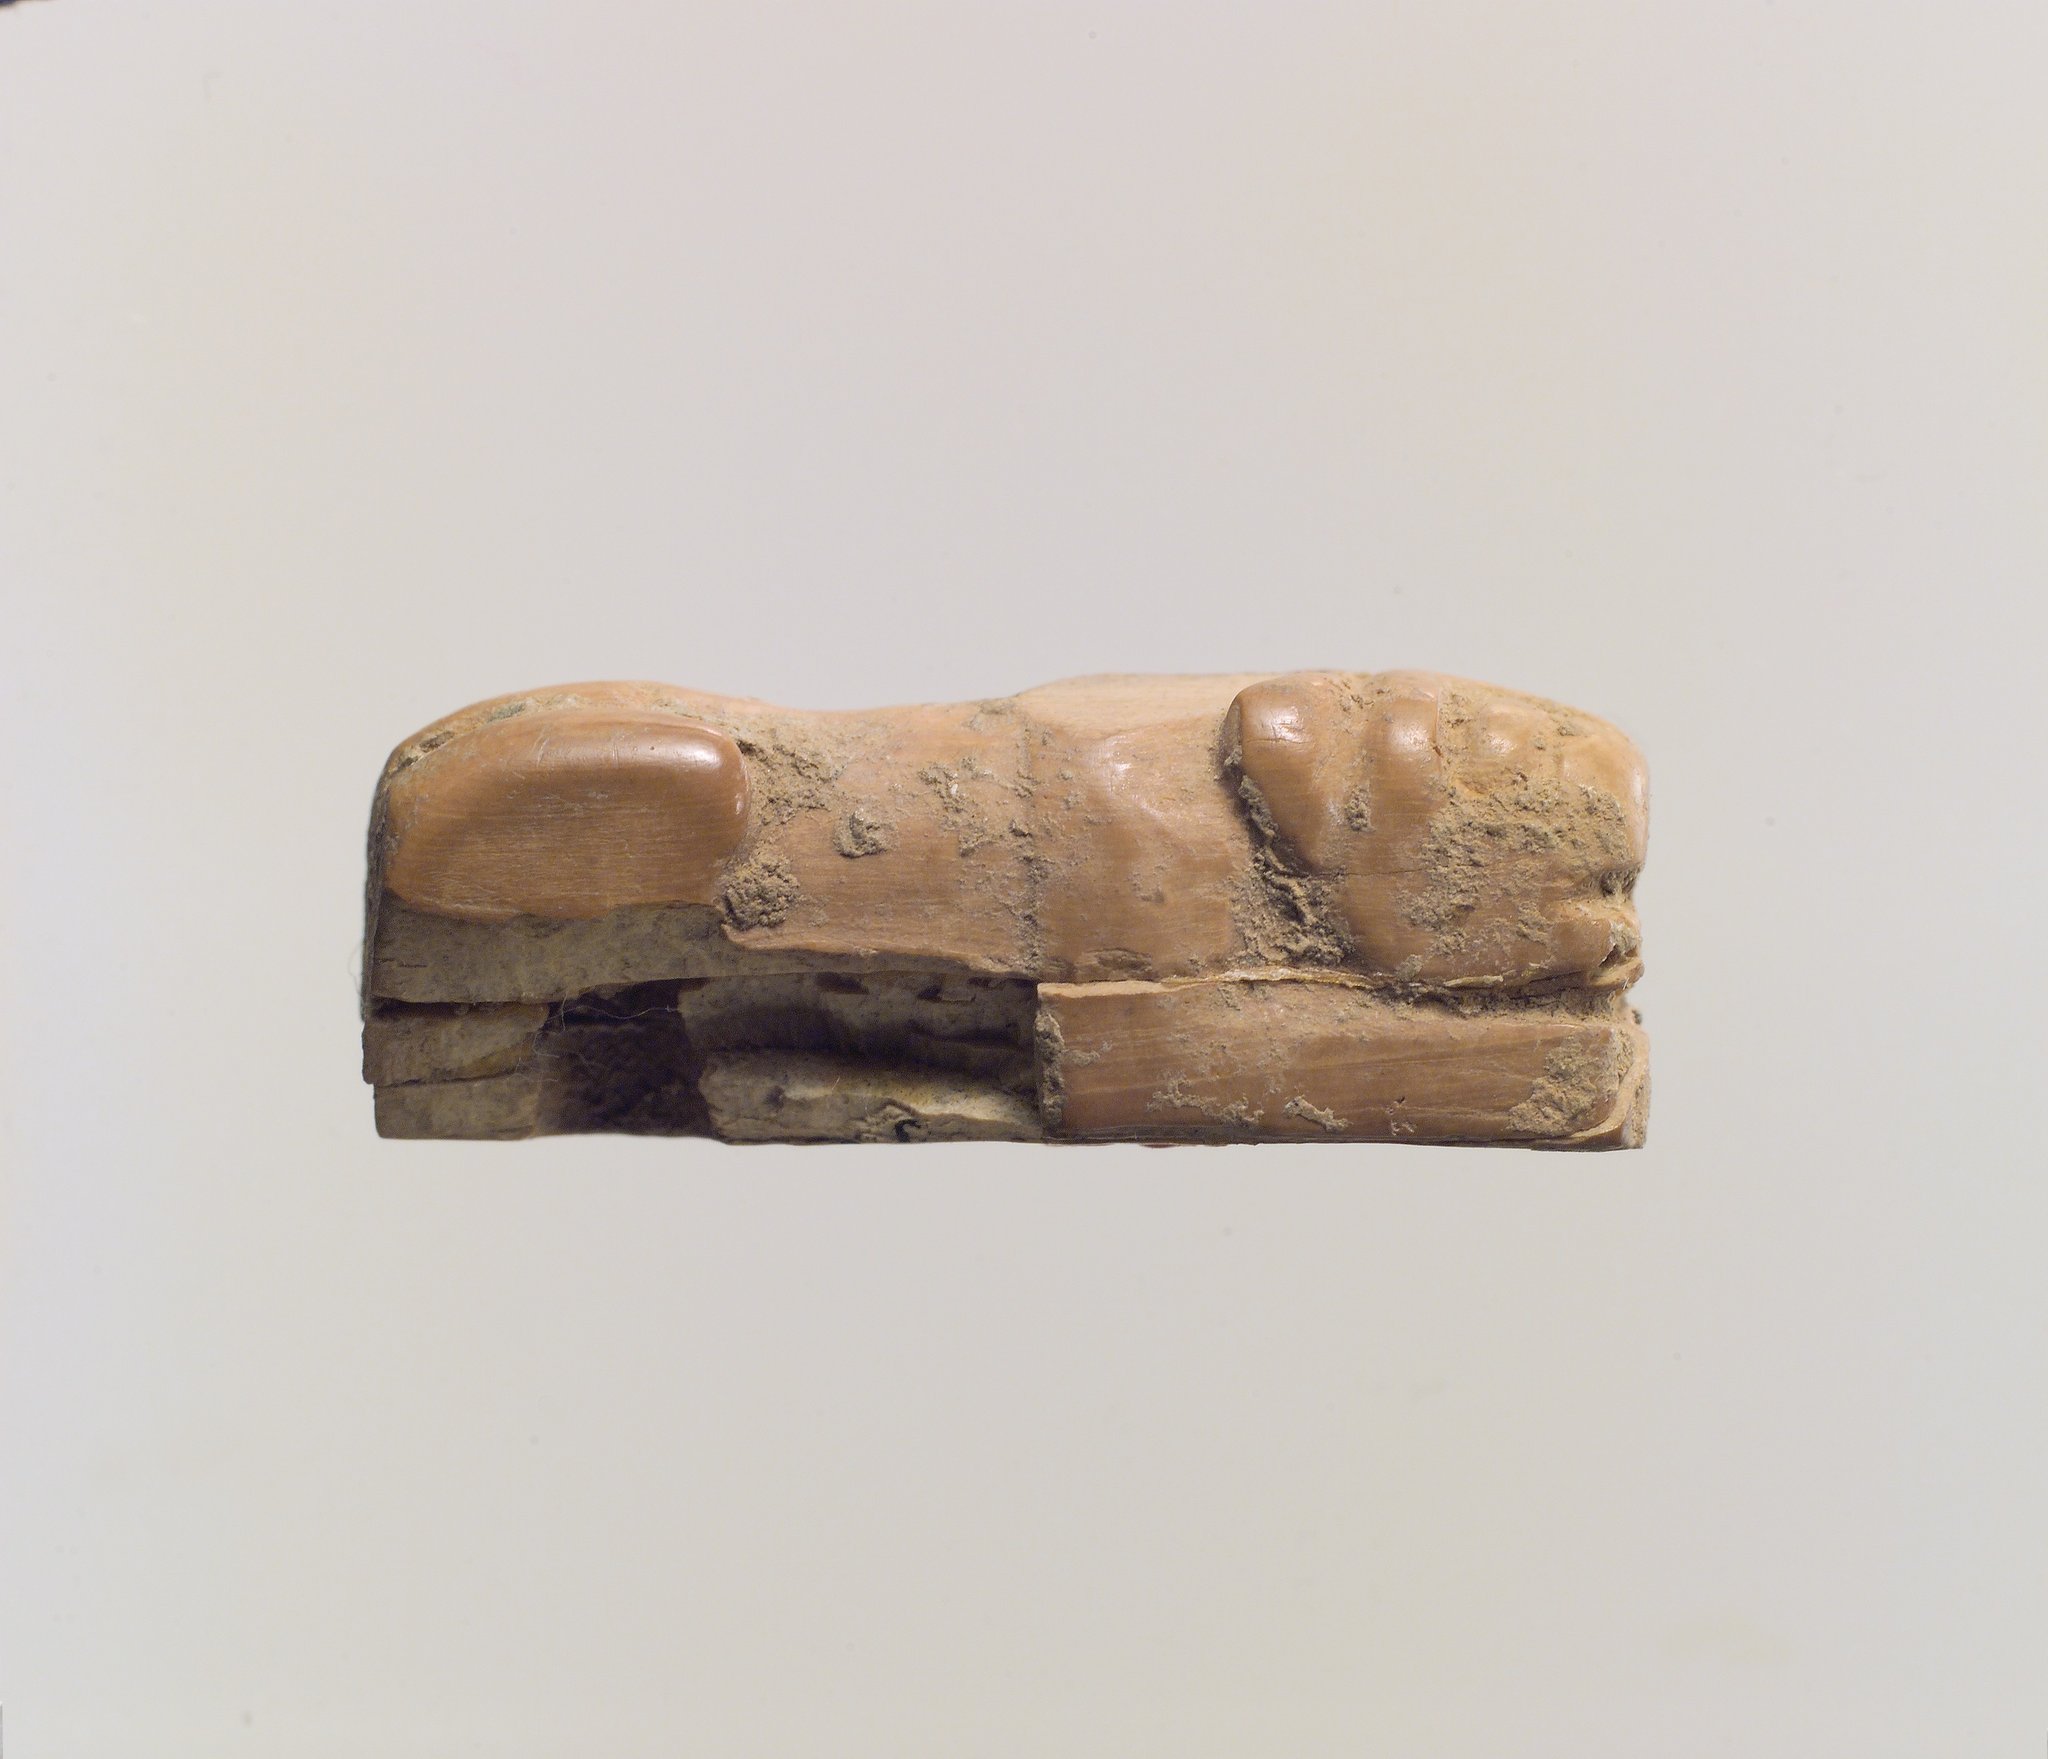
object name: sculpture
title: Figure of crouching lion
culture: iranian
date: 800-601 BCE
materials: ivory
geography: iran, luristan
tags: lions